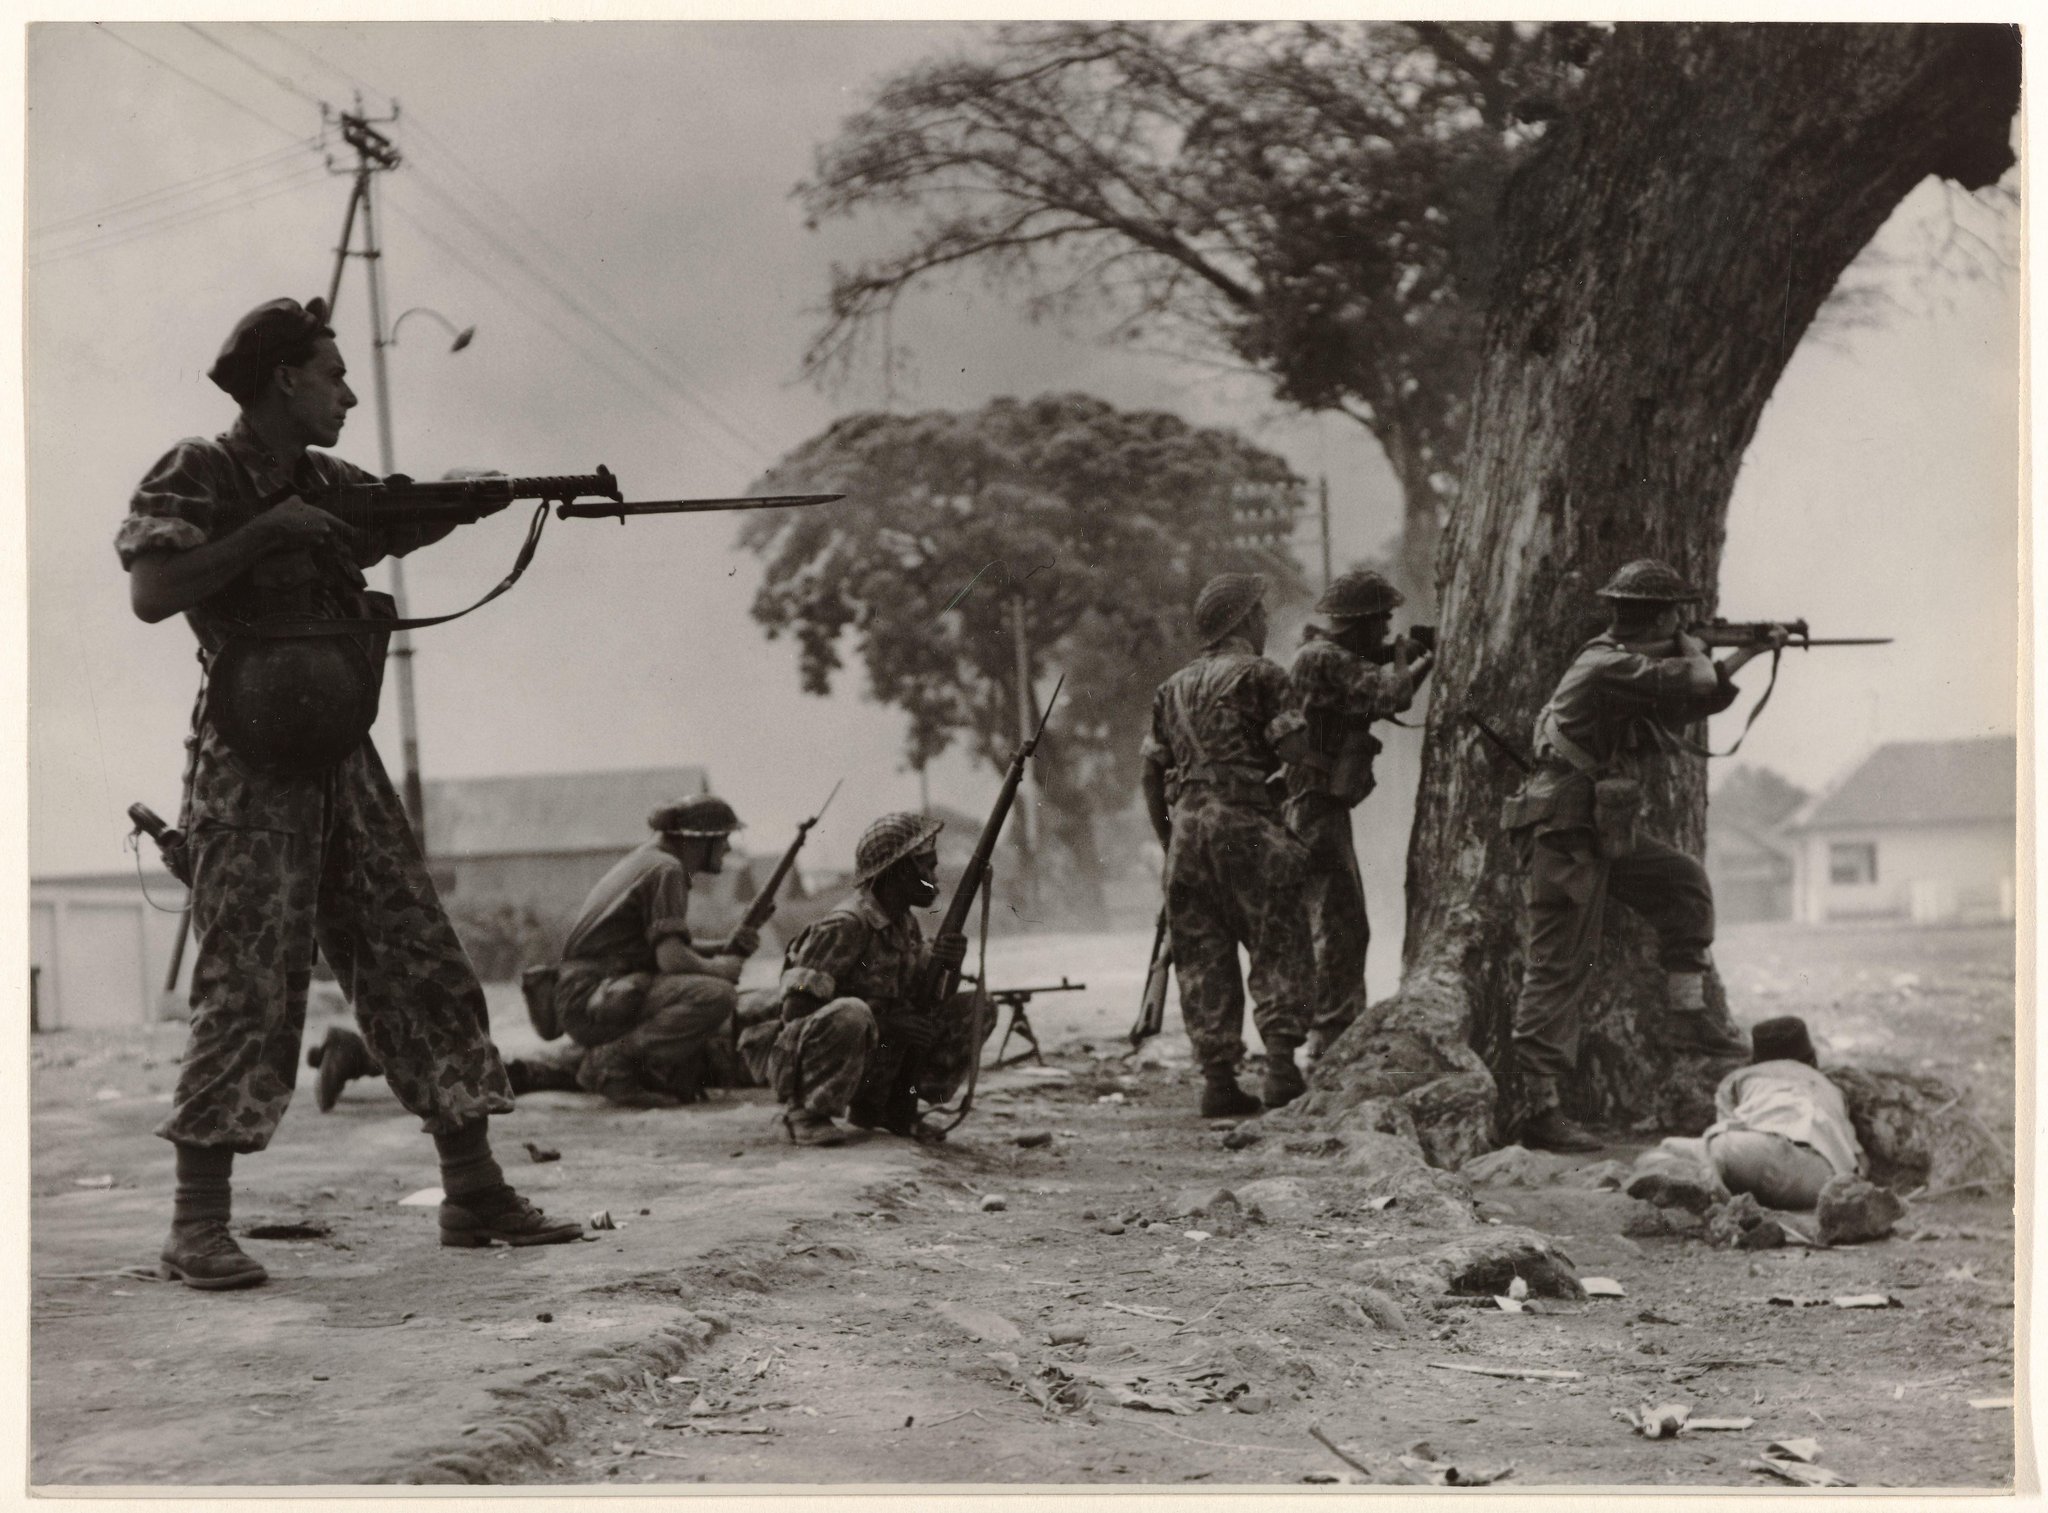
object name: photograph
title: Dutch Soldiers Respond to Gunfire from a Sniper in Malang, Java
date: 1947-1949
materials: photographic support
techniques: photography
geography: java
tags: guerilla warfare, revolution, revolt, java, dutch east indies, the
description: Nederlandse militairen beantwoorden het vuur van een sluipschutter in Malang.